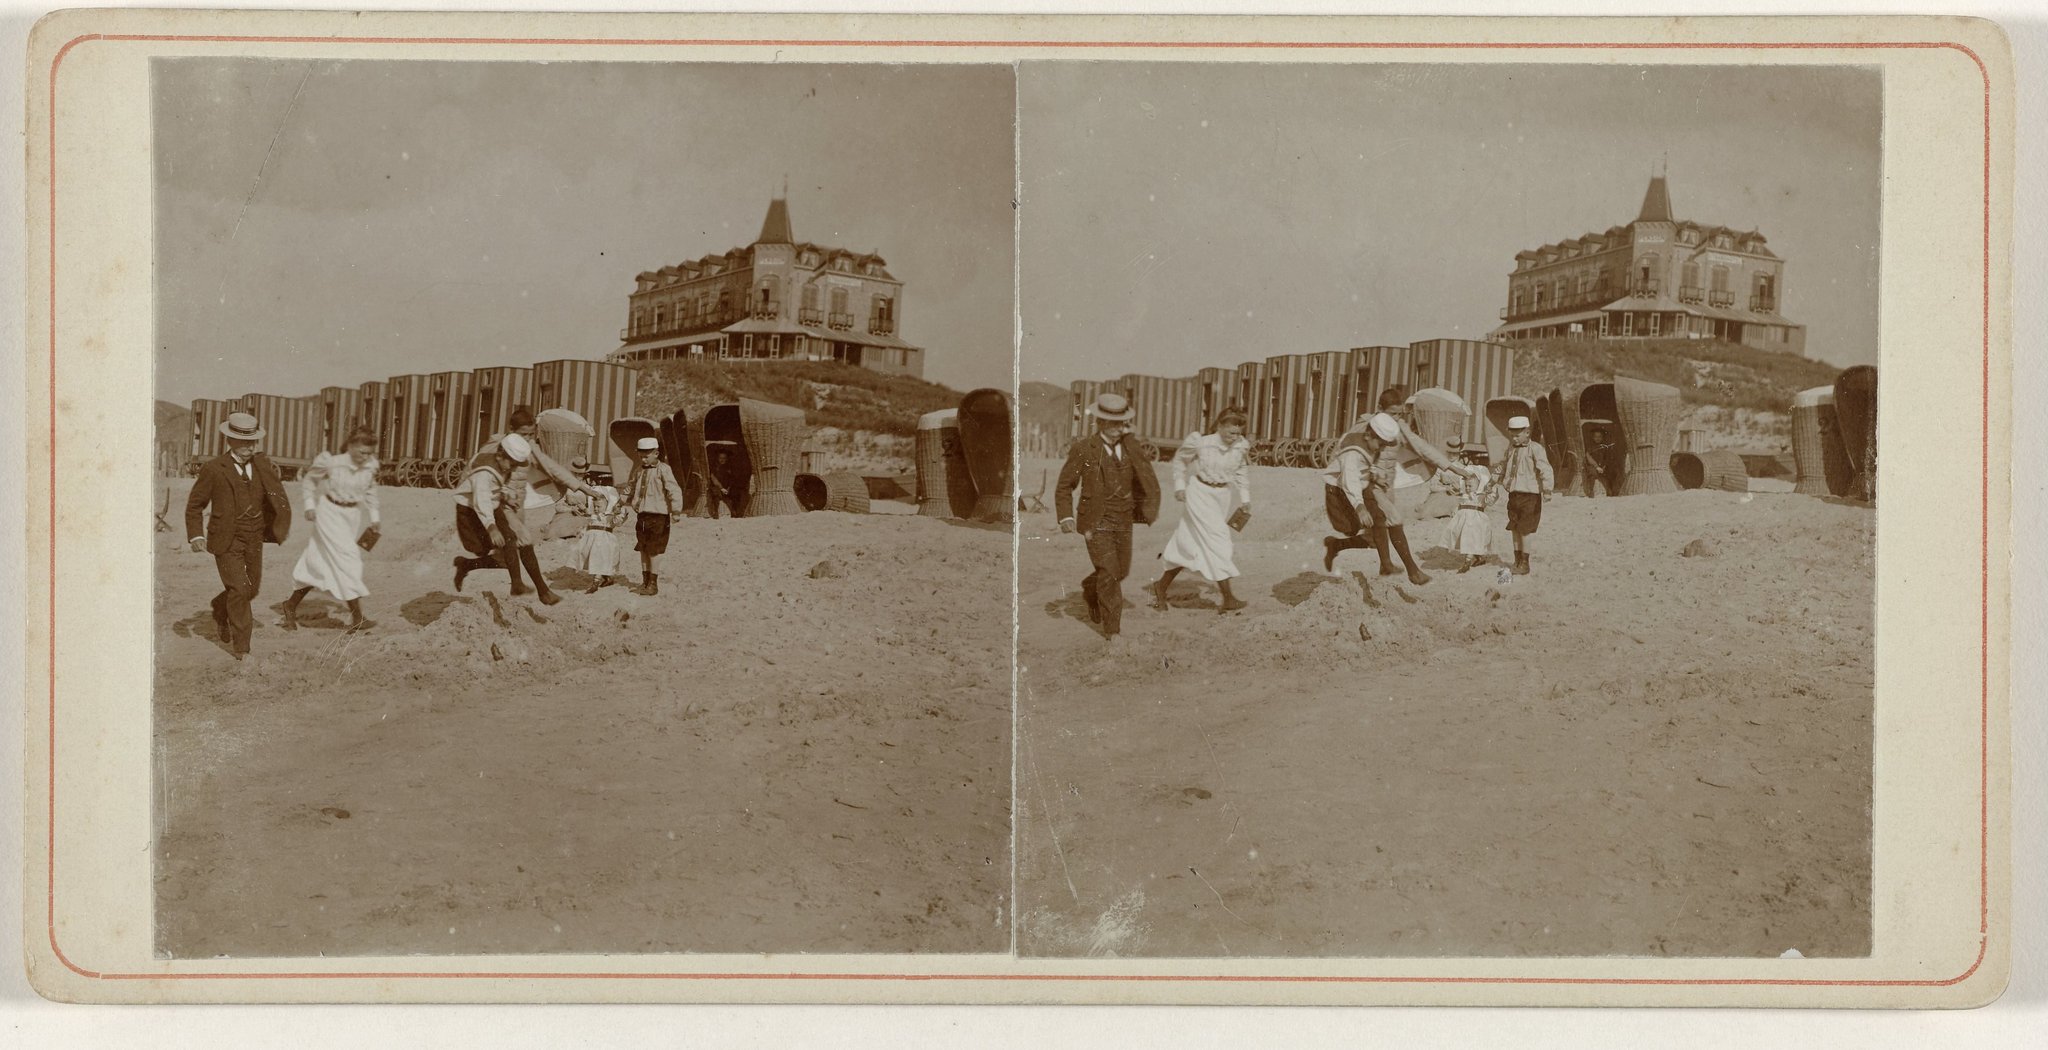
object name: stereograph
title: Stereoscopic Photographs of the Photographer’s Children Running and Jumping, Domburg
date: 1899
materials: cardboard, paper, photographic support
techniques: collodion silver print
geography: netherlands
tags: domburg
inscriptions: annotation: ‘Domburg 1899’